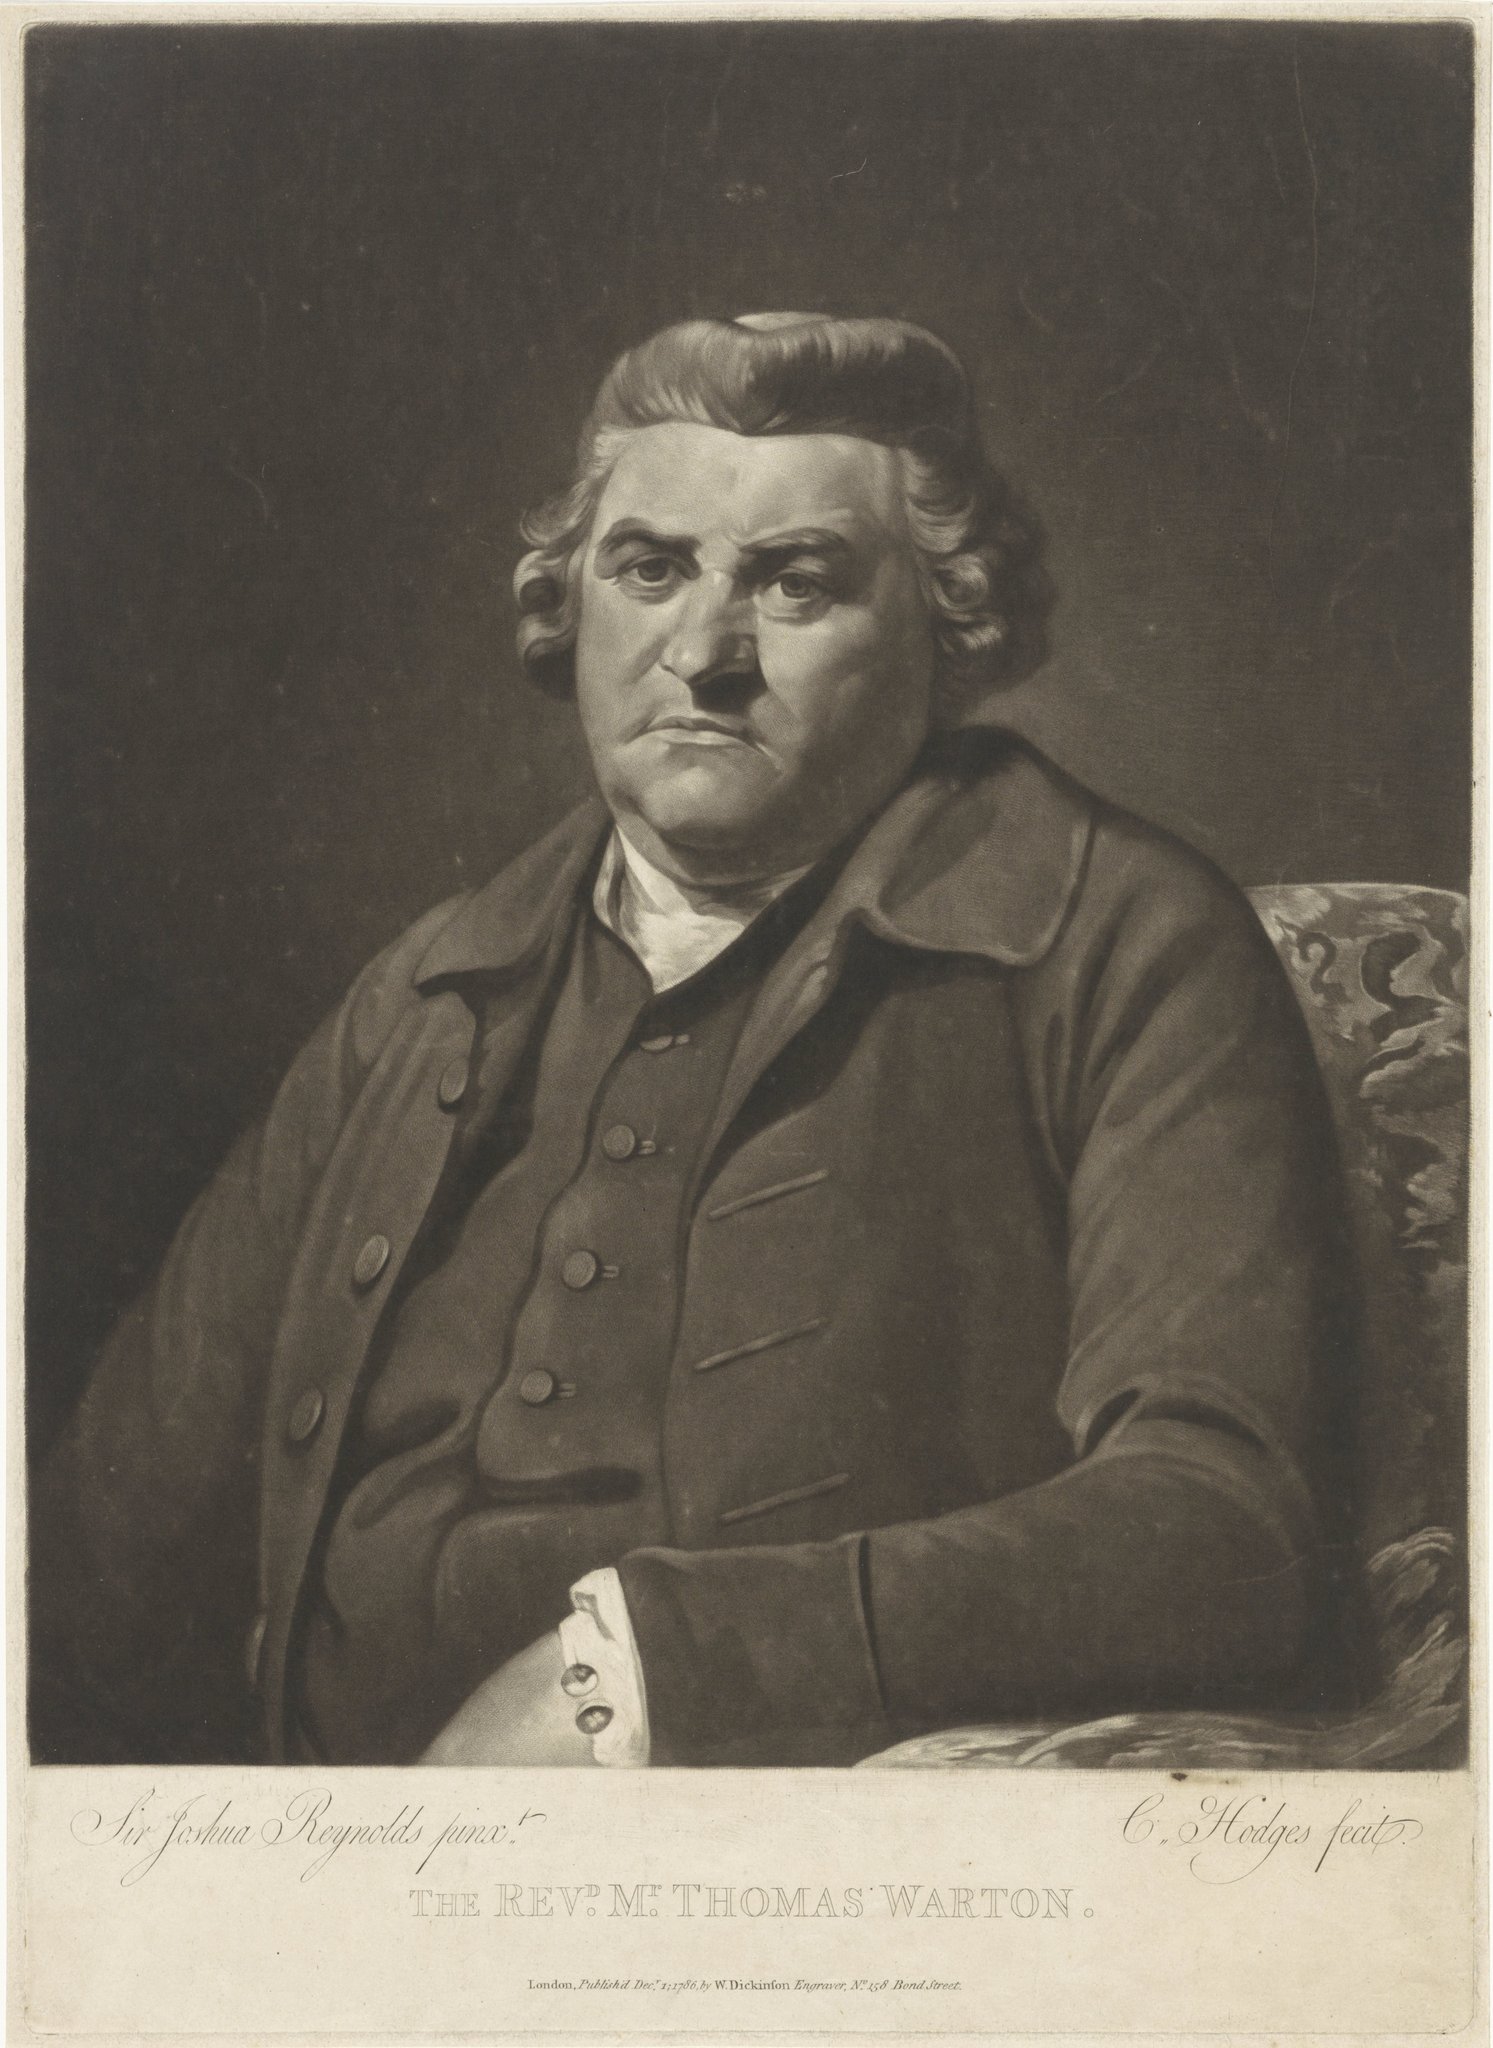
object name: print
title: Portret van Thomas Warton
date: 1786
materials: paper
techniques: engraving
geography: london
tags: basingstoke, oxford, dichter, thomas warton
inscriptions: collector's mark: Lugt 2228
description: De predikant en dichter Thomas Warton zit in een stoel.